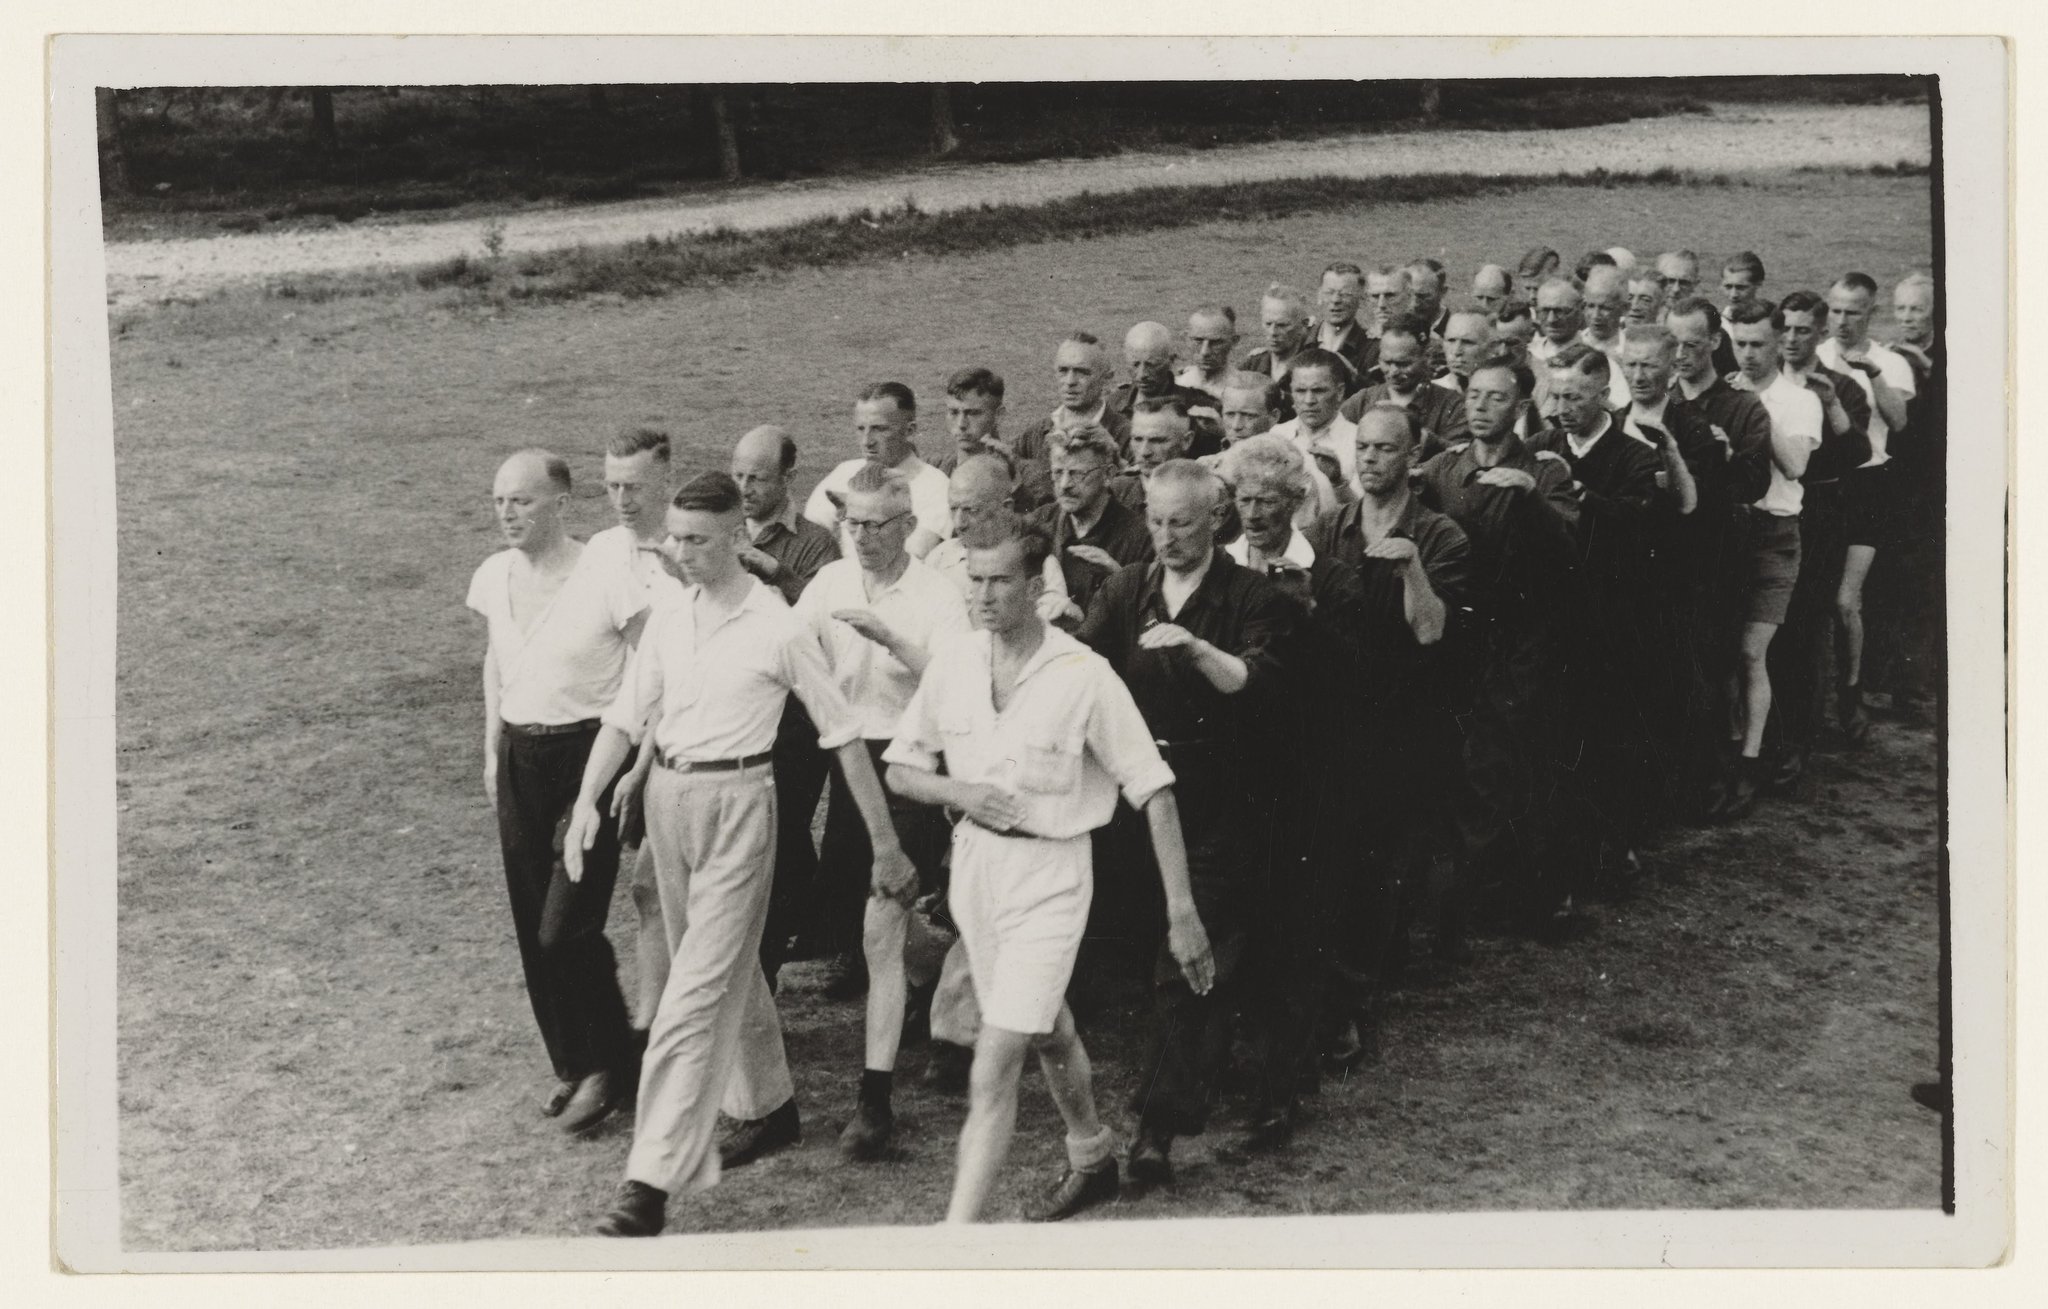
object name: photograph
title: NSB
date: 1943-1944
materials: photographic support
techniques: gelatin silver print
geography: lunteren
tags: military training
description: Drie rijen mannen lopen over een grasveld. Handen op de schouders van de man voor hem. Rechts mannen in overalls, sommige anderen in korte broek of lange broek. De mannen worden opgeleid op de Scheleberg in Lunteren voor de Landwacht. Opgericht in november 1943 als beschermingsorganisatie voor de NSB na een aantal aanslagen op vooraanstaande NSBers. Al snel kwam de Landwacht onder controle van de Duitsers en werd ook als hulppolitie ingezet. De Scheleberg werd gebouwd als vakantieoord voor de leden van de Algemeene bond voor handels- en kantoorbedienden.